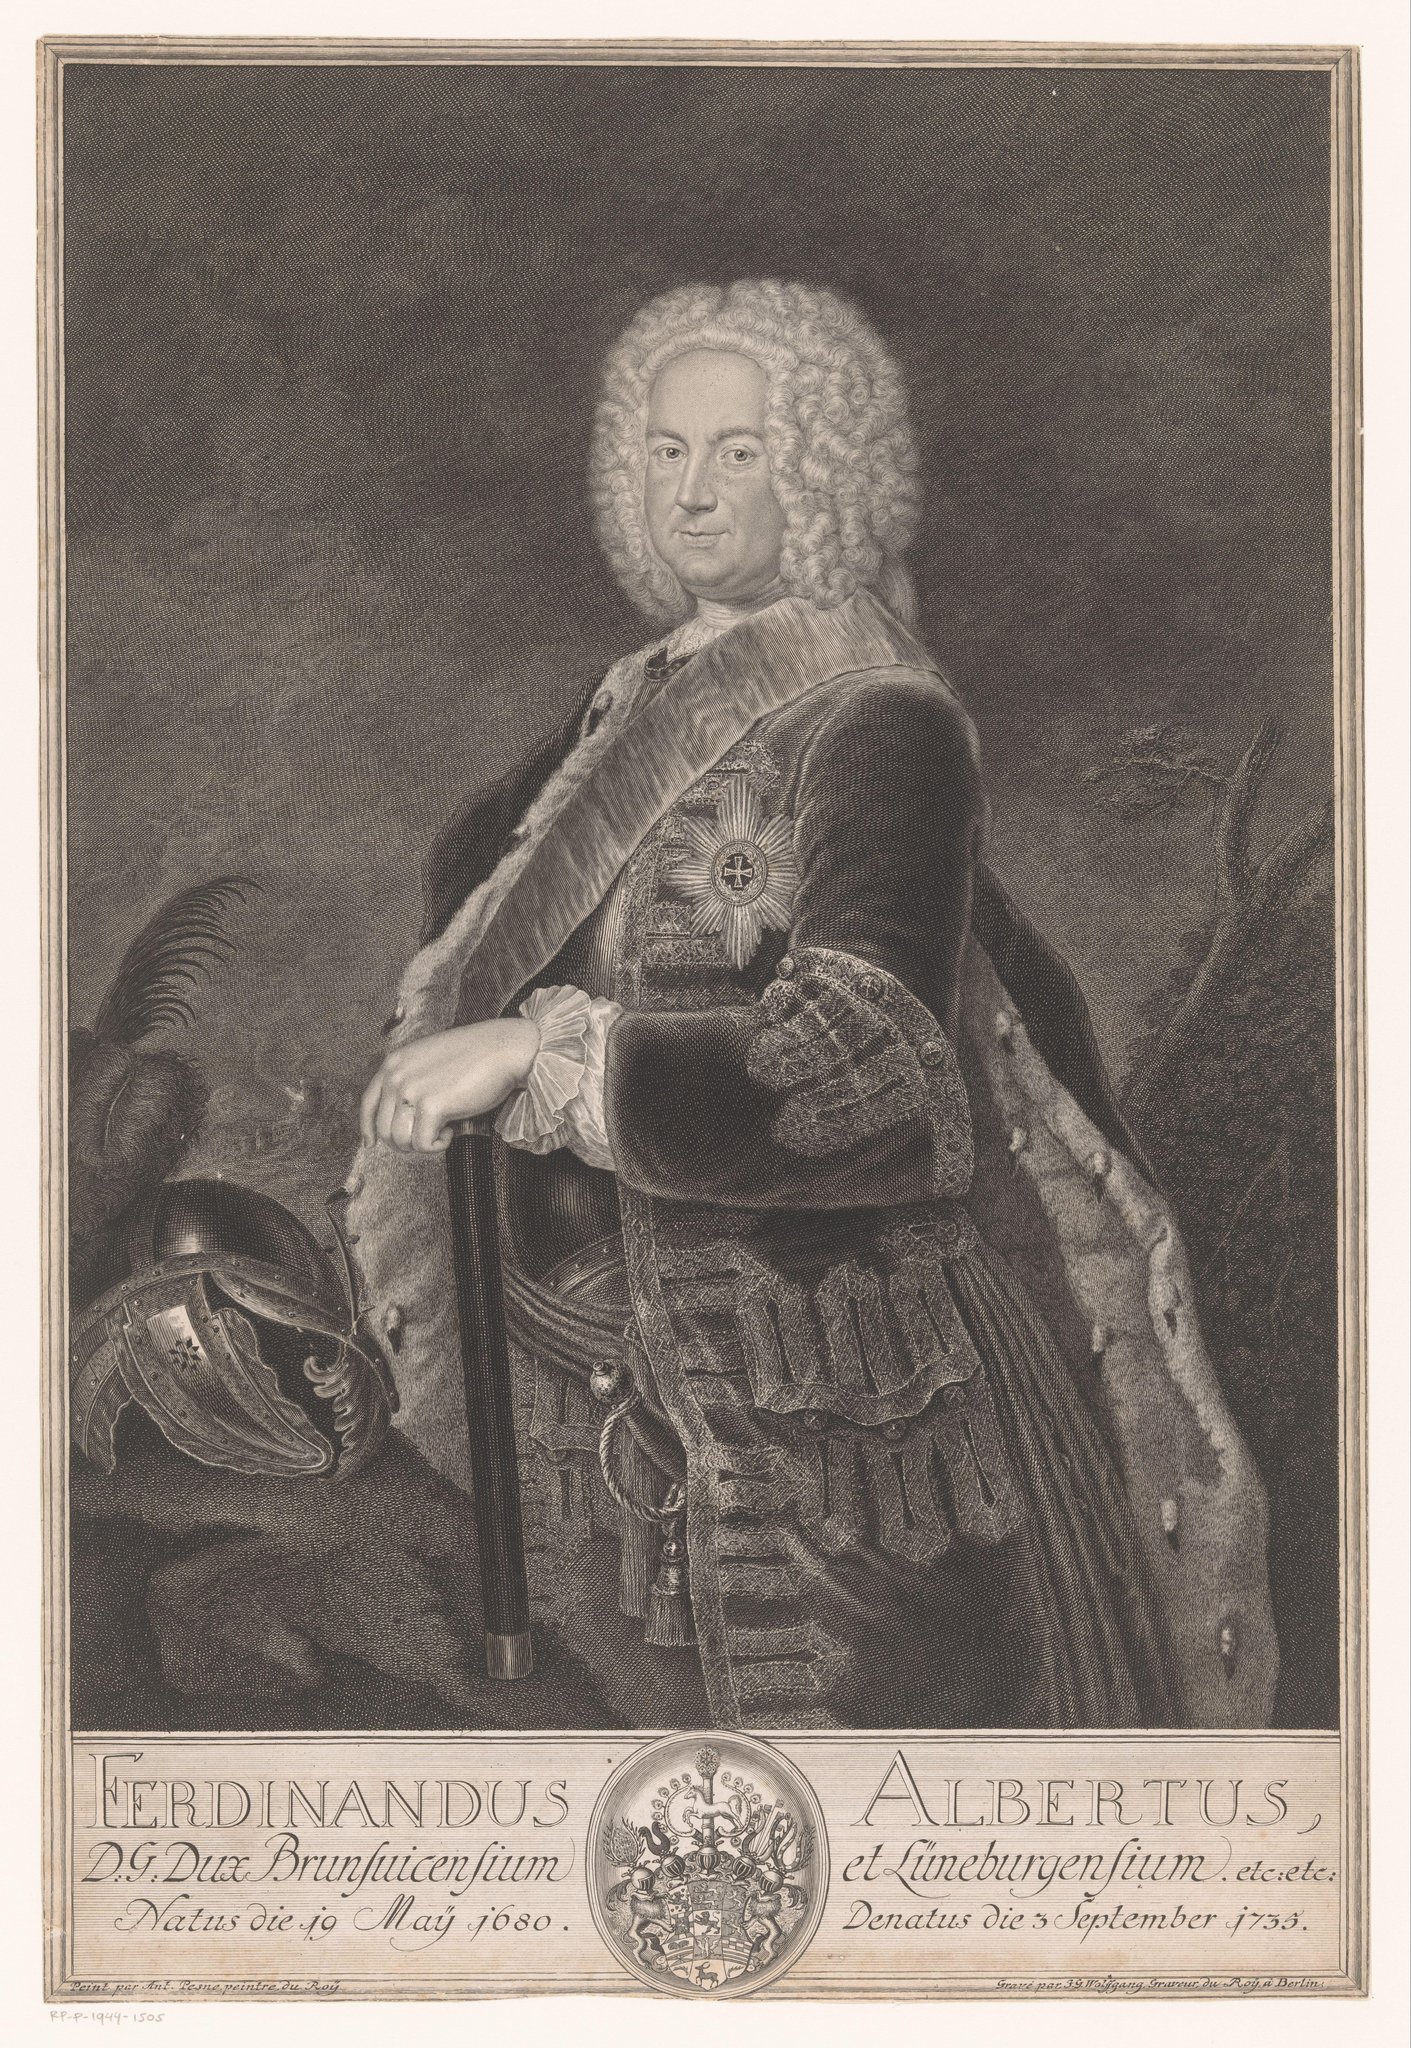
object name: print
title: Portret van Ferdinand Albrecht II van Brunswijk-Wolfenbüttel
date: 1735-1744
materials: paper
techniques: engraving, etching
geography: berlin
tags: historical persons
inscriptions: collector's mark: Lugt 2228